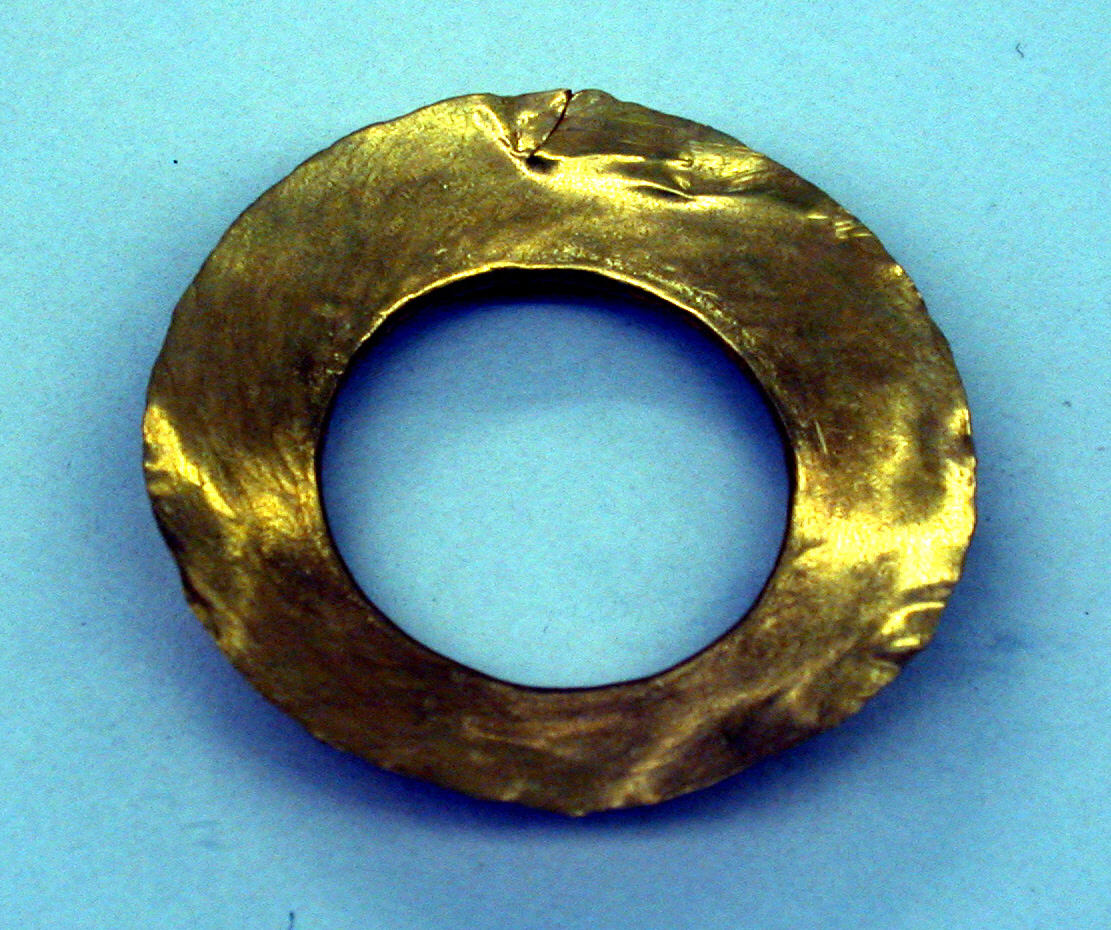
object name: ear ornament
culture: cuyo island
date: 1301-1500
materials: gold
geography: philippines